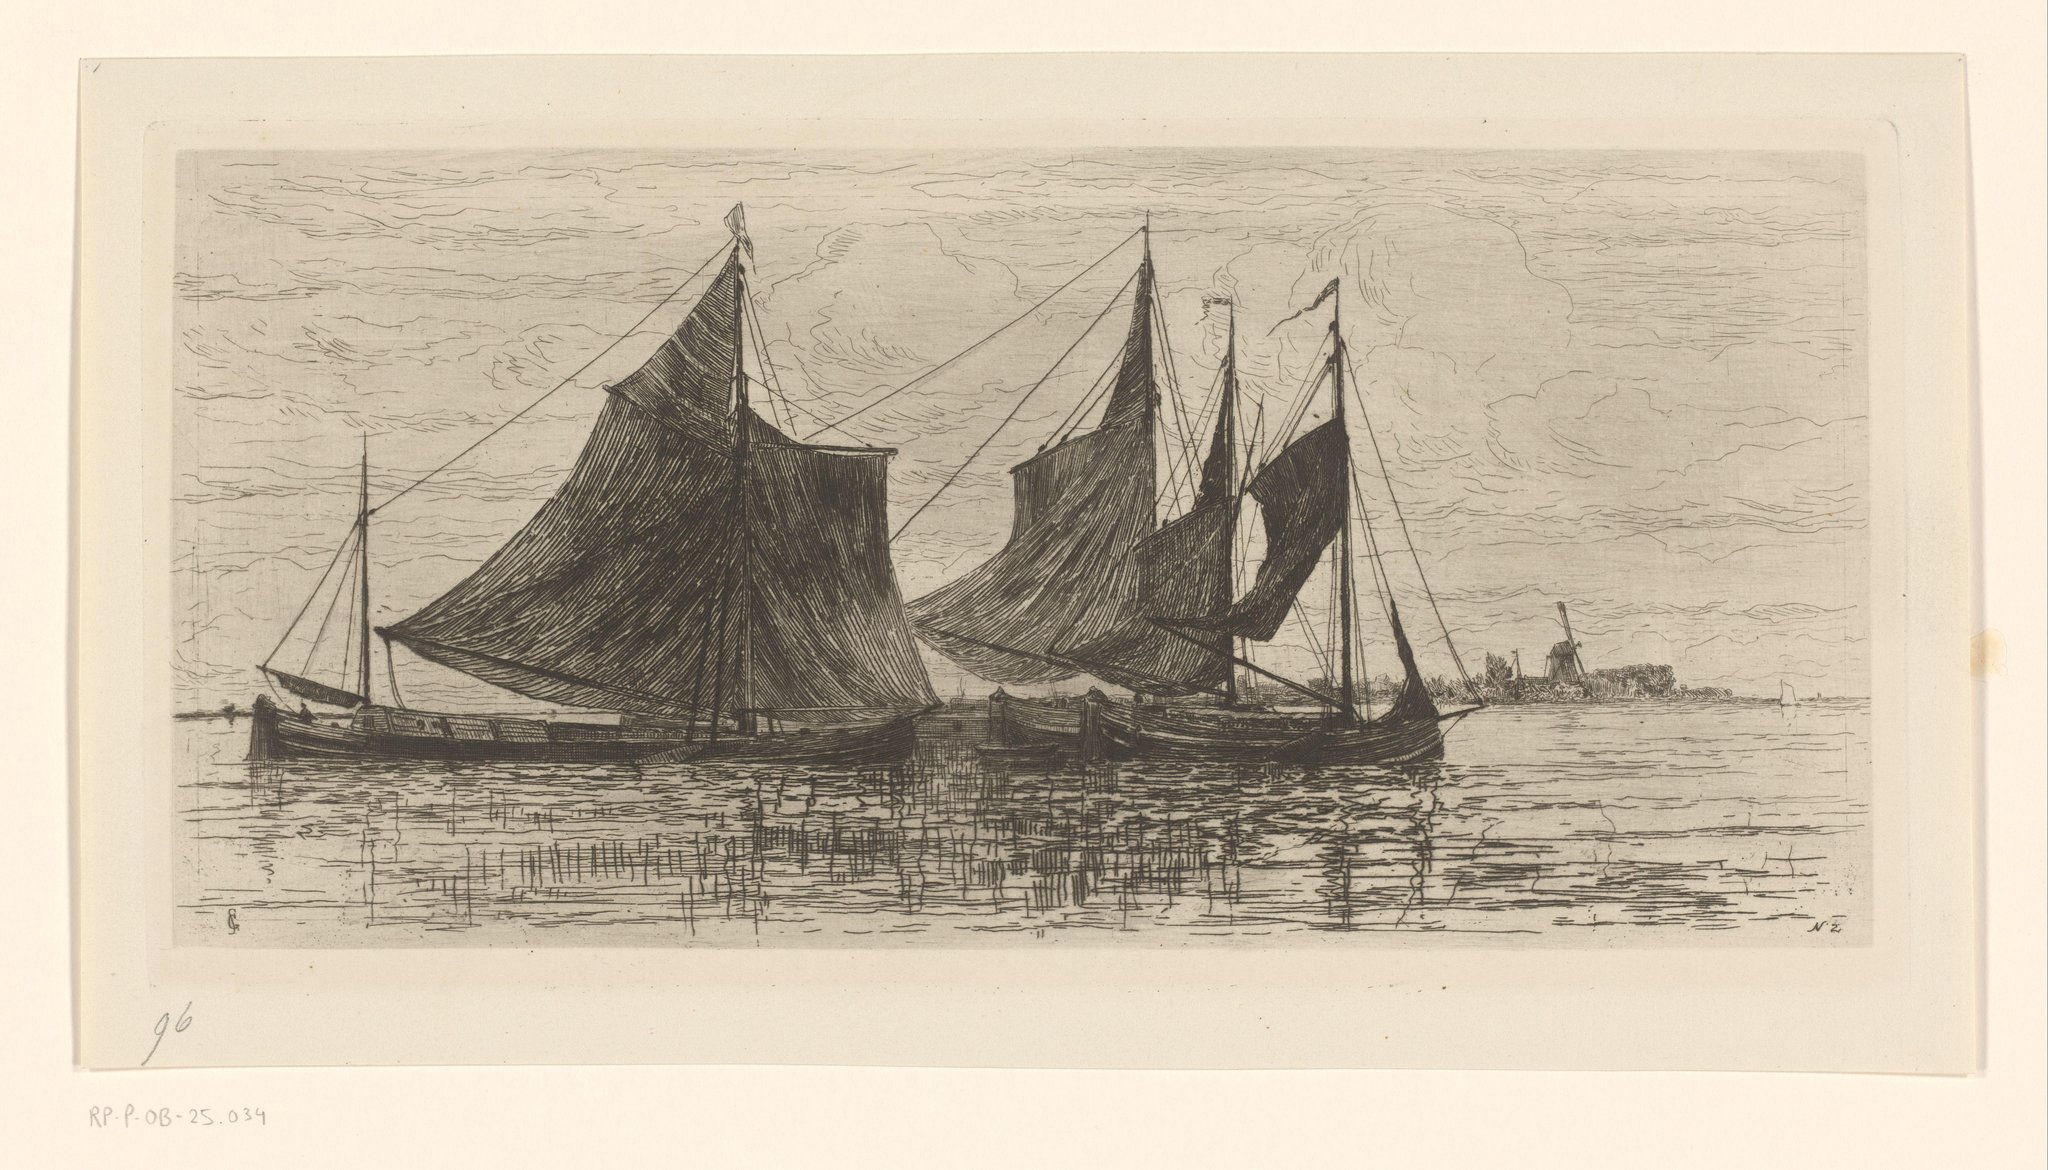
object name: print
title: La Hollande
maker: carel nicolaas storm van s-gravesande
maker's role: draughtsman, print maker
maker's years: 1841-1924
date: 1877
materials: paper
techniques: etching, intaglio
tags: sailing-ship, sailing-boat (+ arrival, coming to anchor, at anchor), dordrecht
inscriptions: collector's mark: Lugt 2228